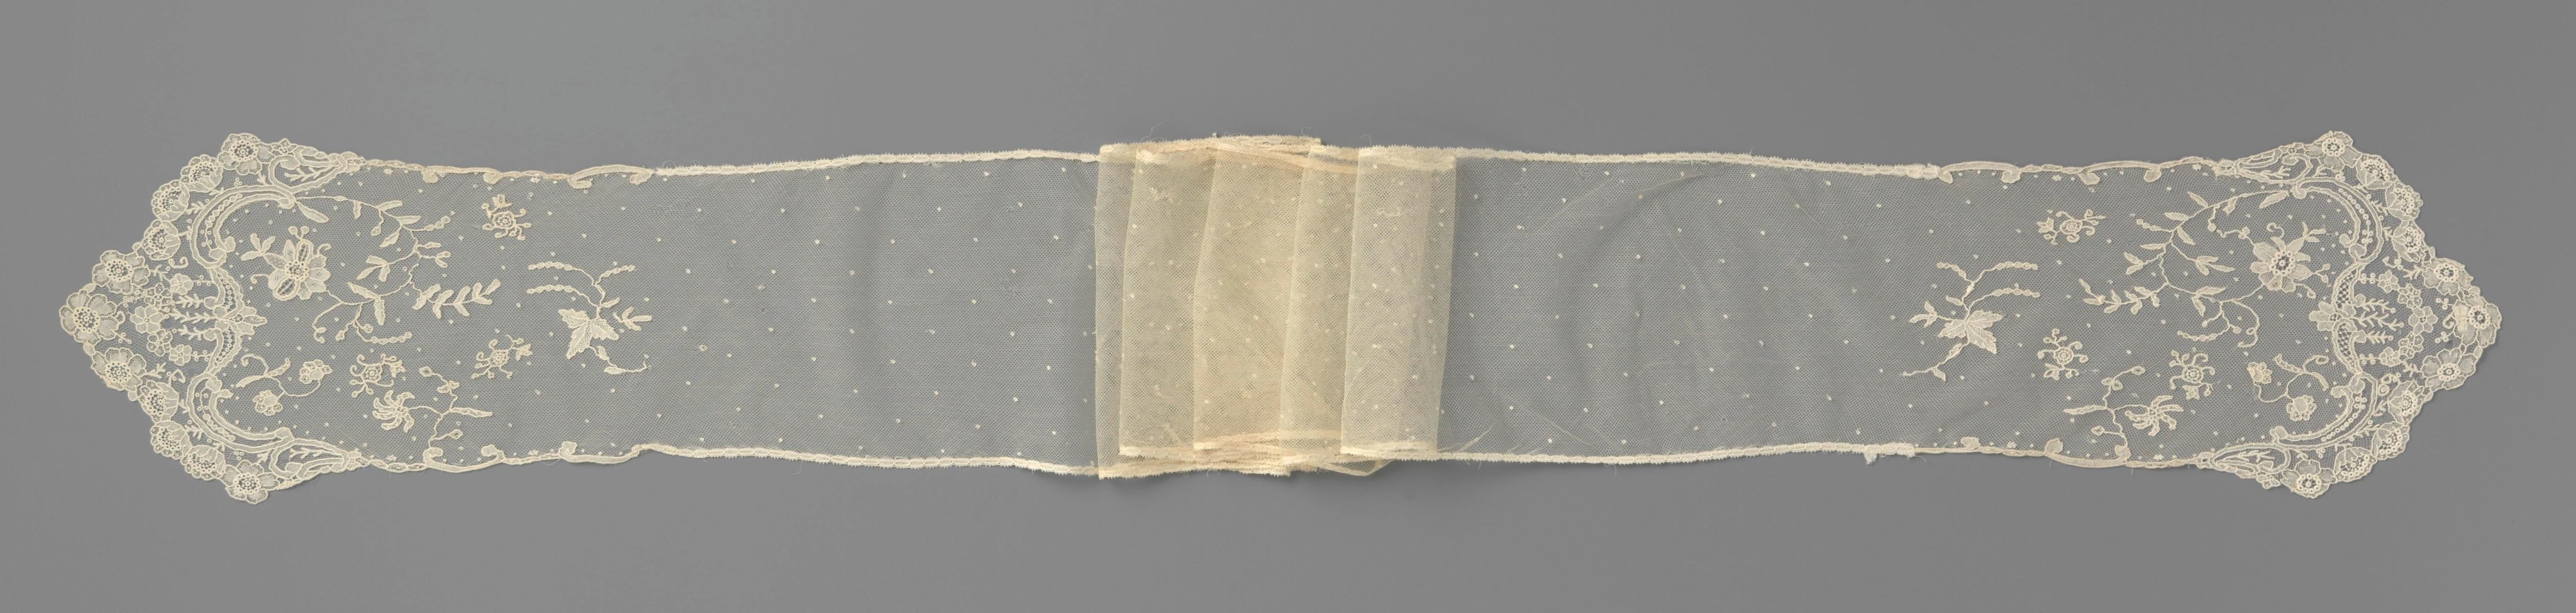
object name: lappet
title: Barbe van naaldkant met moesjesfond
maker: Anonymous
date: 1860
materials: linen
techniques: needle lace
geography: brussels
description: Rechthoekig van vorm met iets verbrede, driehoekige uiteinden. Het midden is met wijd verspreide moesjes bezaaid en door een smal getorst randje omgeven. De uiteinden vertonen assymetrische bloem- en bladranken en symmetrische, holle en bolle C-voluten, waaromheen aaneengerijde klaproosjes. Het fond gazé is vervangen door een tullen ondergrond. Point de gaze de Bruxelles.